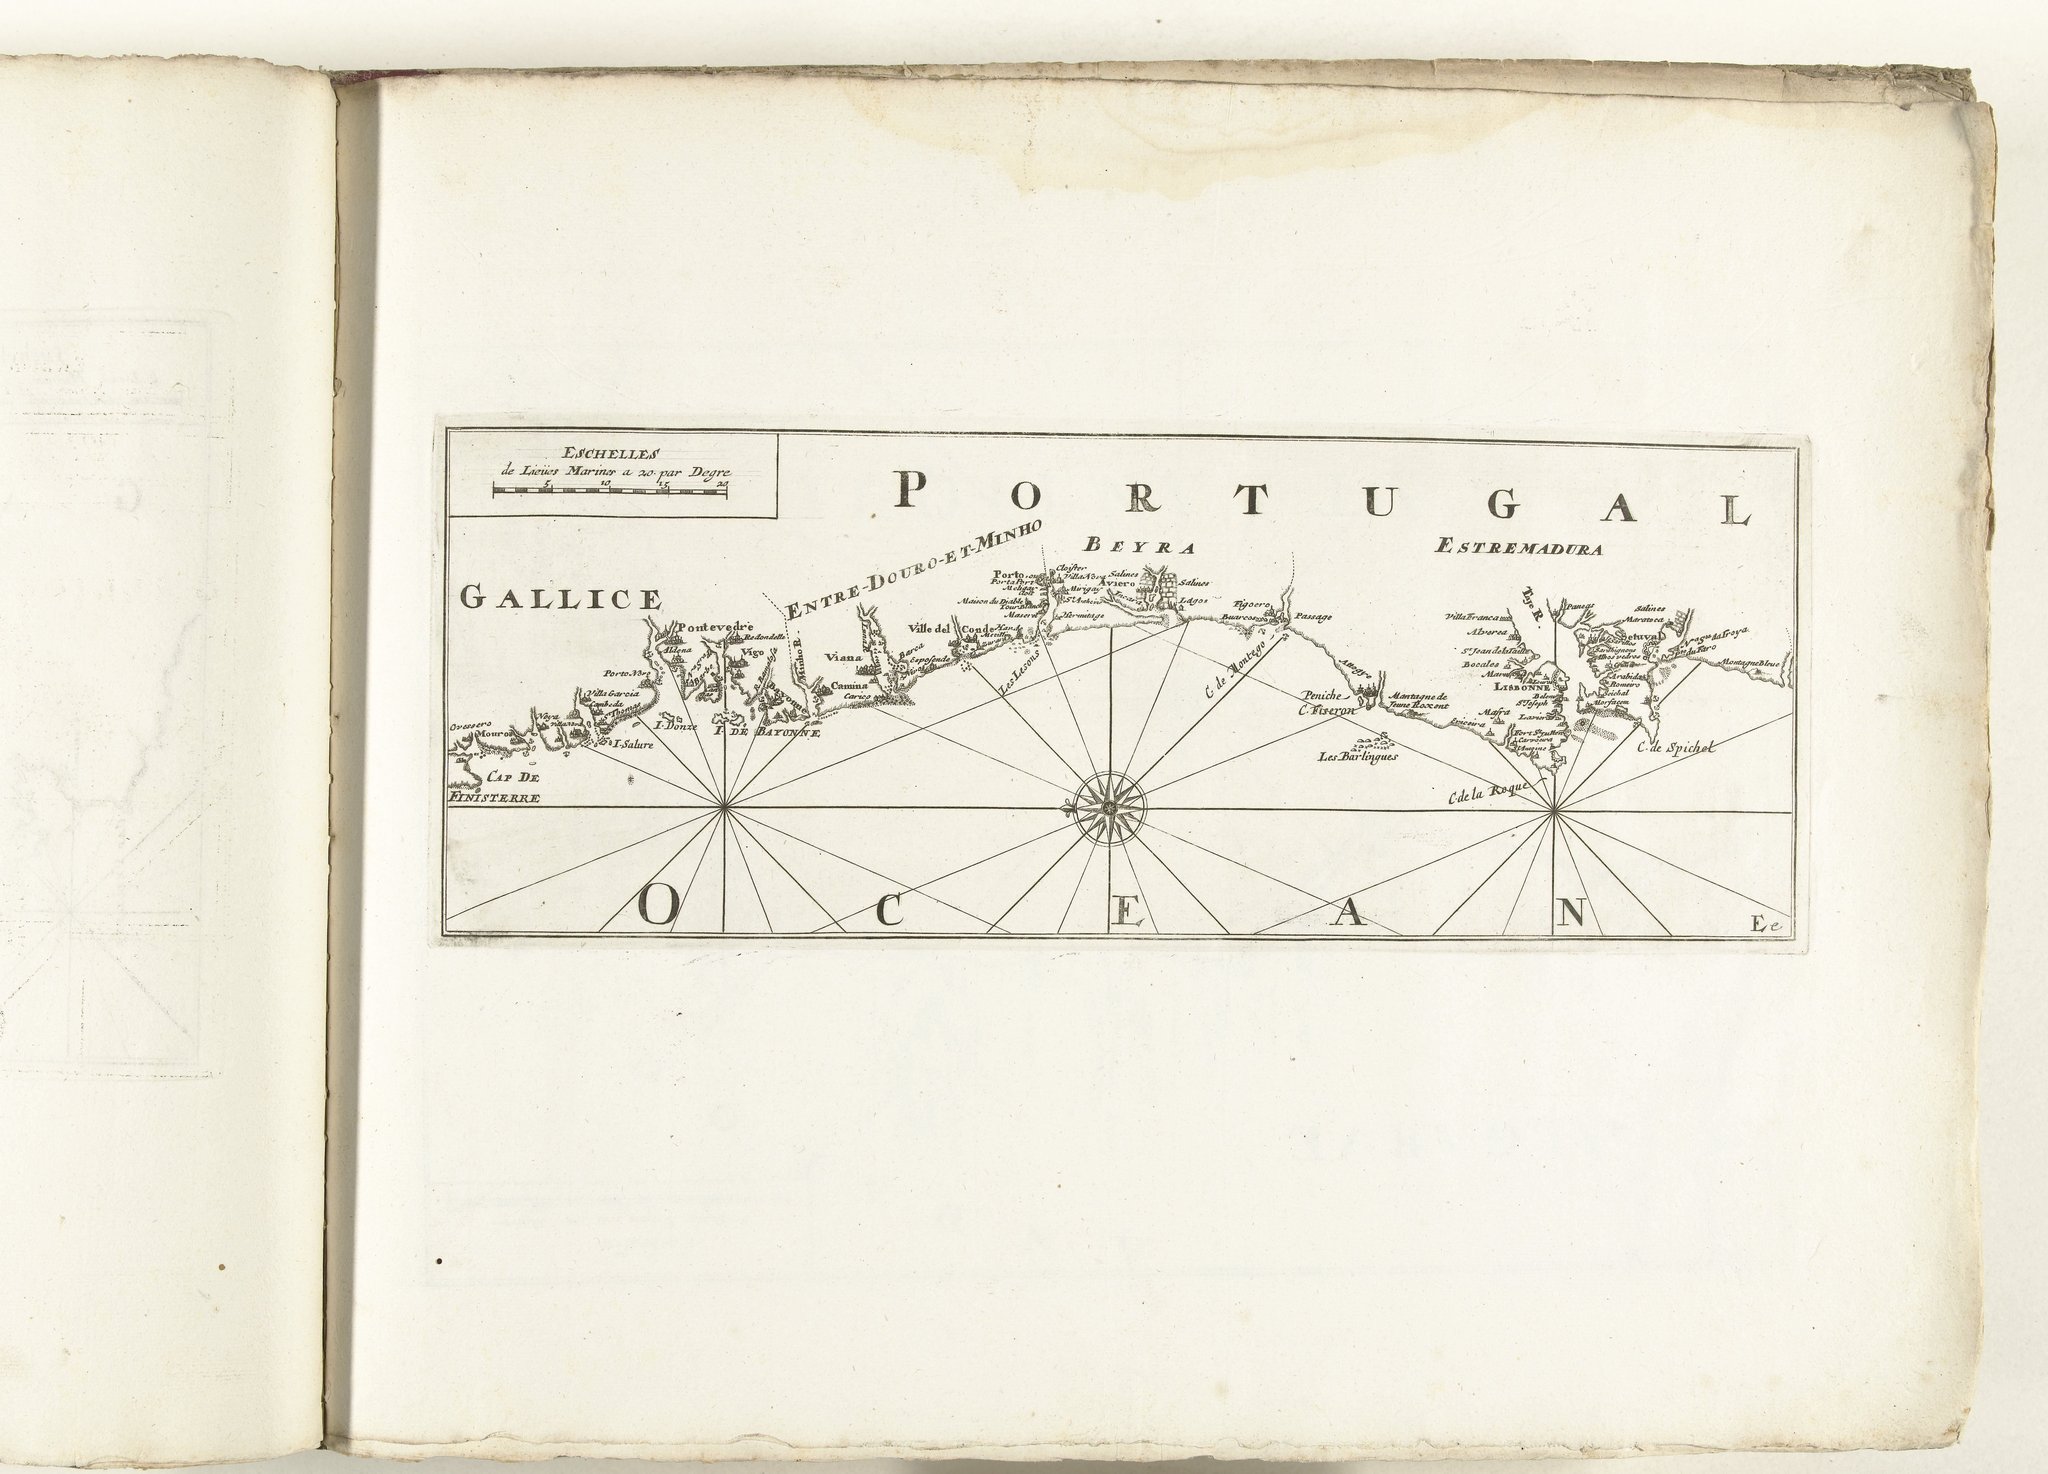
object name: map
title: Kaart van de westkust van Portugal, ca. 1702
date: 1702-1703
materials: paper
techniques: etching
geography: amsterdam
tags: maps of separate countries or regions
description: Kaart van de westkust van Portugal tot aan Lissabon. Gemerkt rechtsonder: Ee. Onderdeel van het tweede van twee delen van het prentwerk: Les costes de France et d'Espagne (oftewel deel 14 van: Les Forces de l'Europe, Asie, Afrique et Amerique), uitgegeven ca. 1702. Het prentwerk bestaat in totaal uit 43 gemerkte platen van de kust van Frankrijk en Spanje, in het kader van de Spaanse Successieoorlog. Deze platen zijn gekopieerd naar anonieme Franse platen oorspronkelijk uitgegeven door Nicolas de Fer te Parijs. Titel en opschriften in de plaat in het Frans.